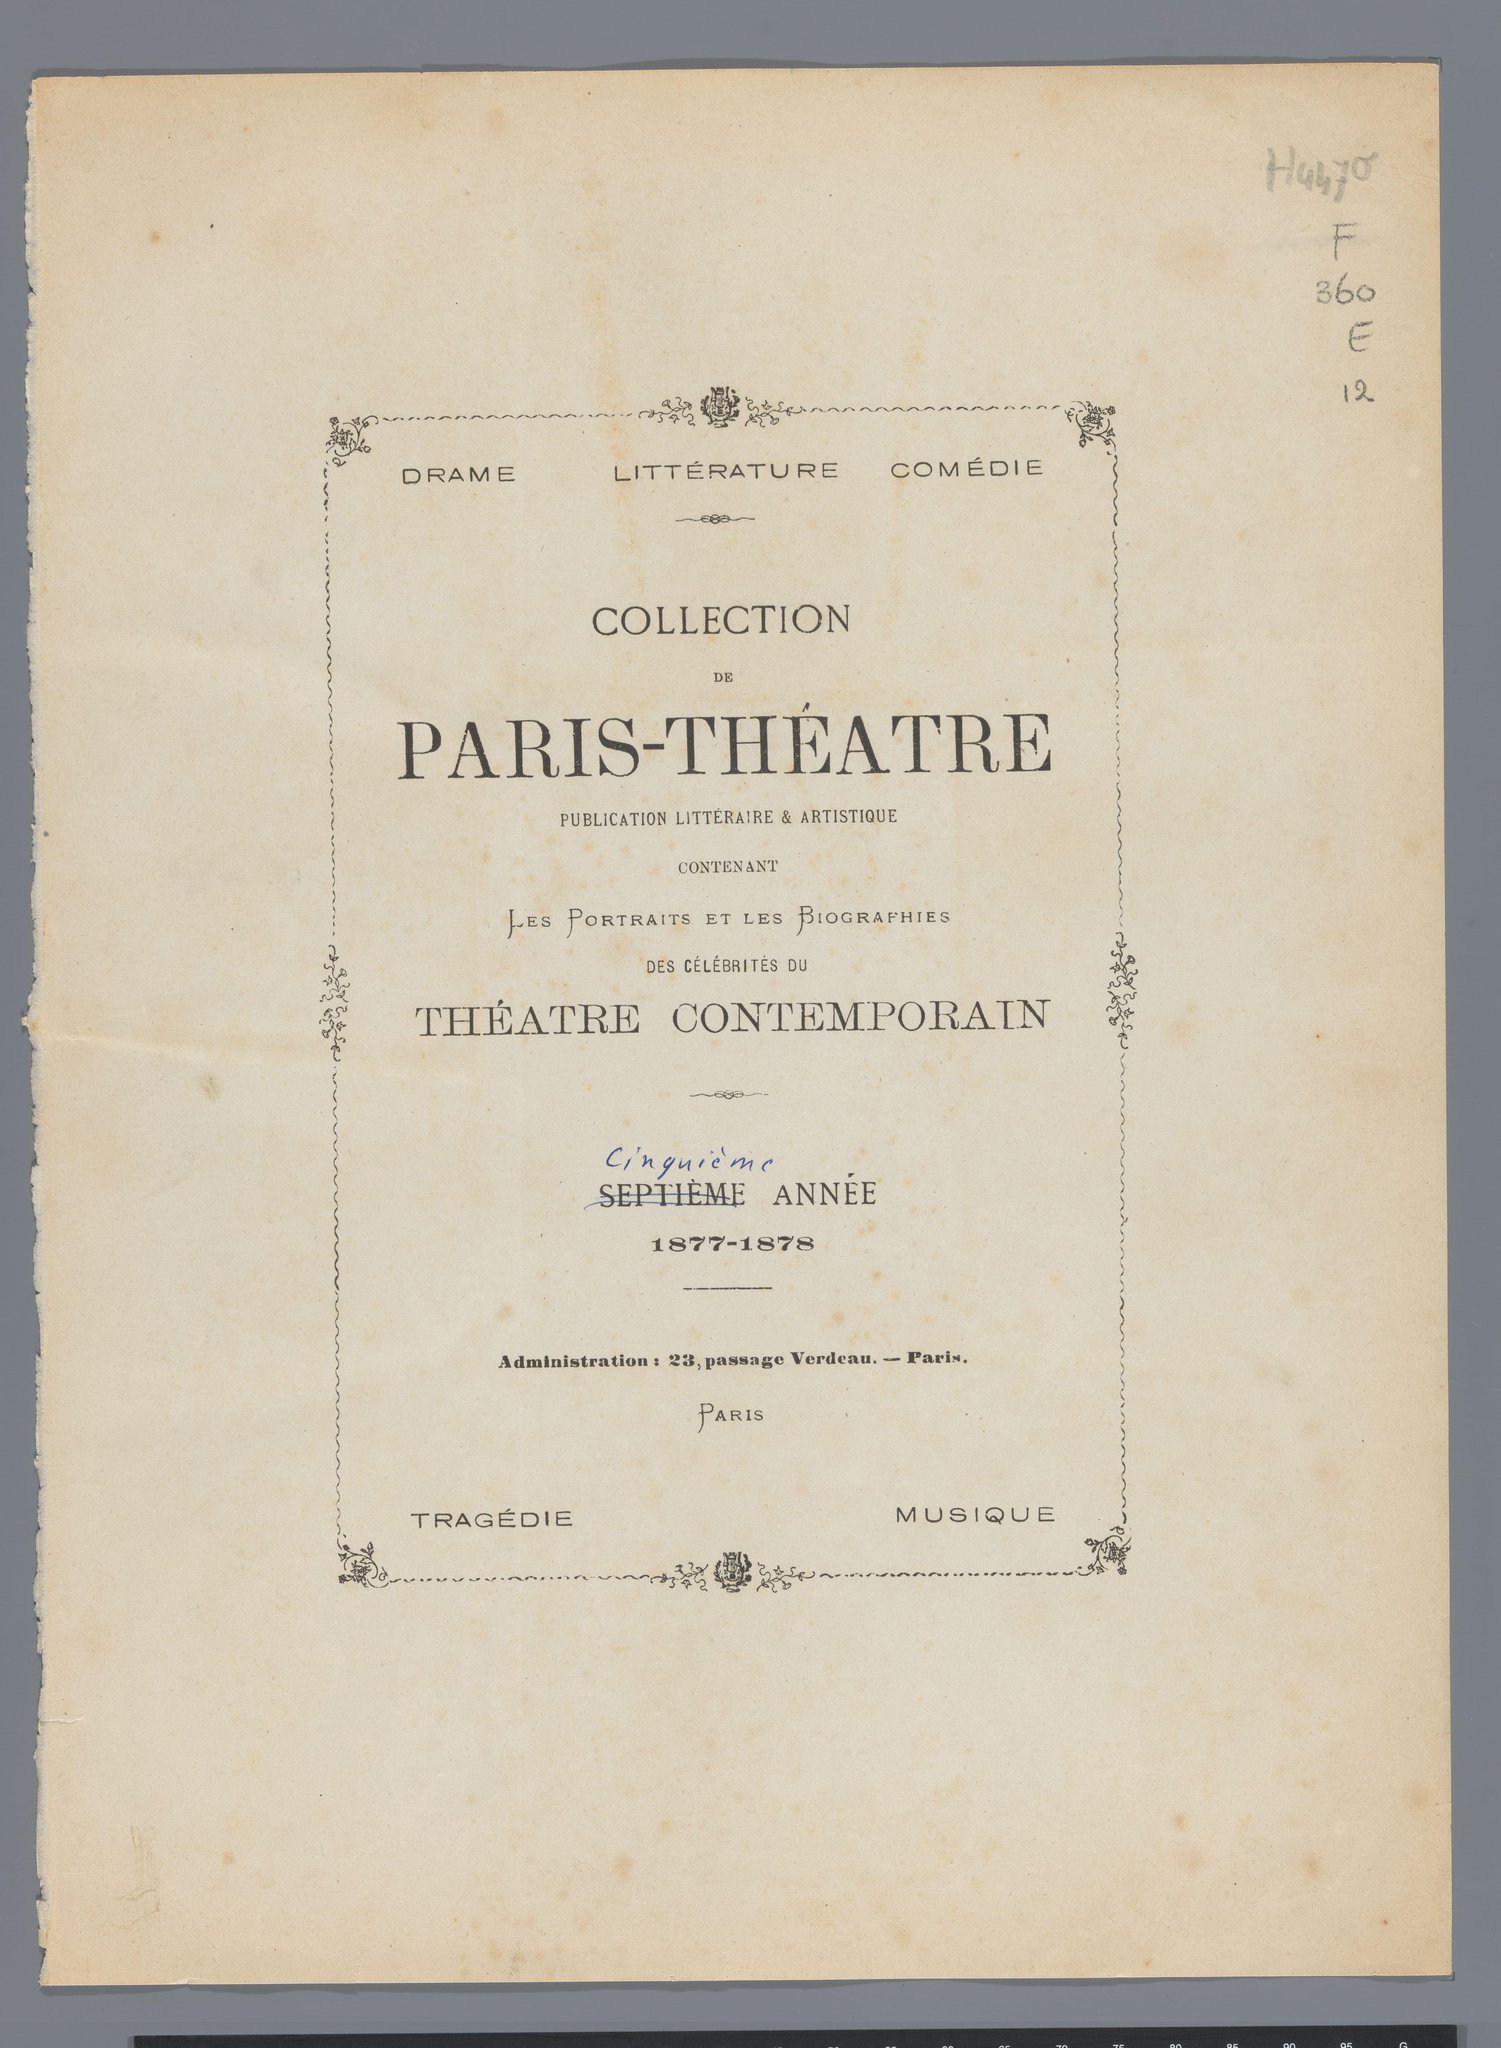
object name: wrapper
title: Paris-Portrait: ancien Paris-Theatre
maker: eugène paz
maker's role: journalist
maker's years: 1835-1901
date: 1878-1880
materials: cardboard, paper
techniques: printing, woodburytype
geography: paris